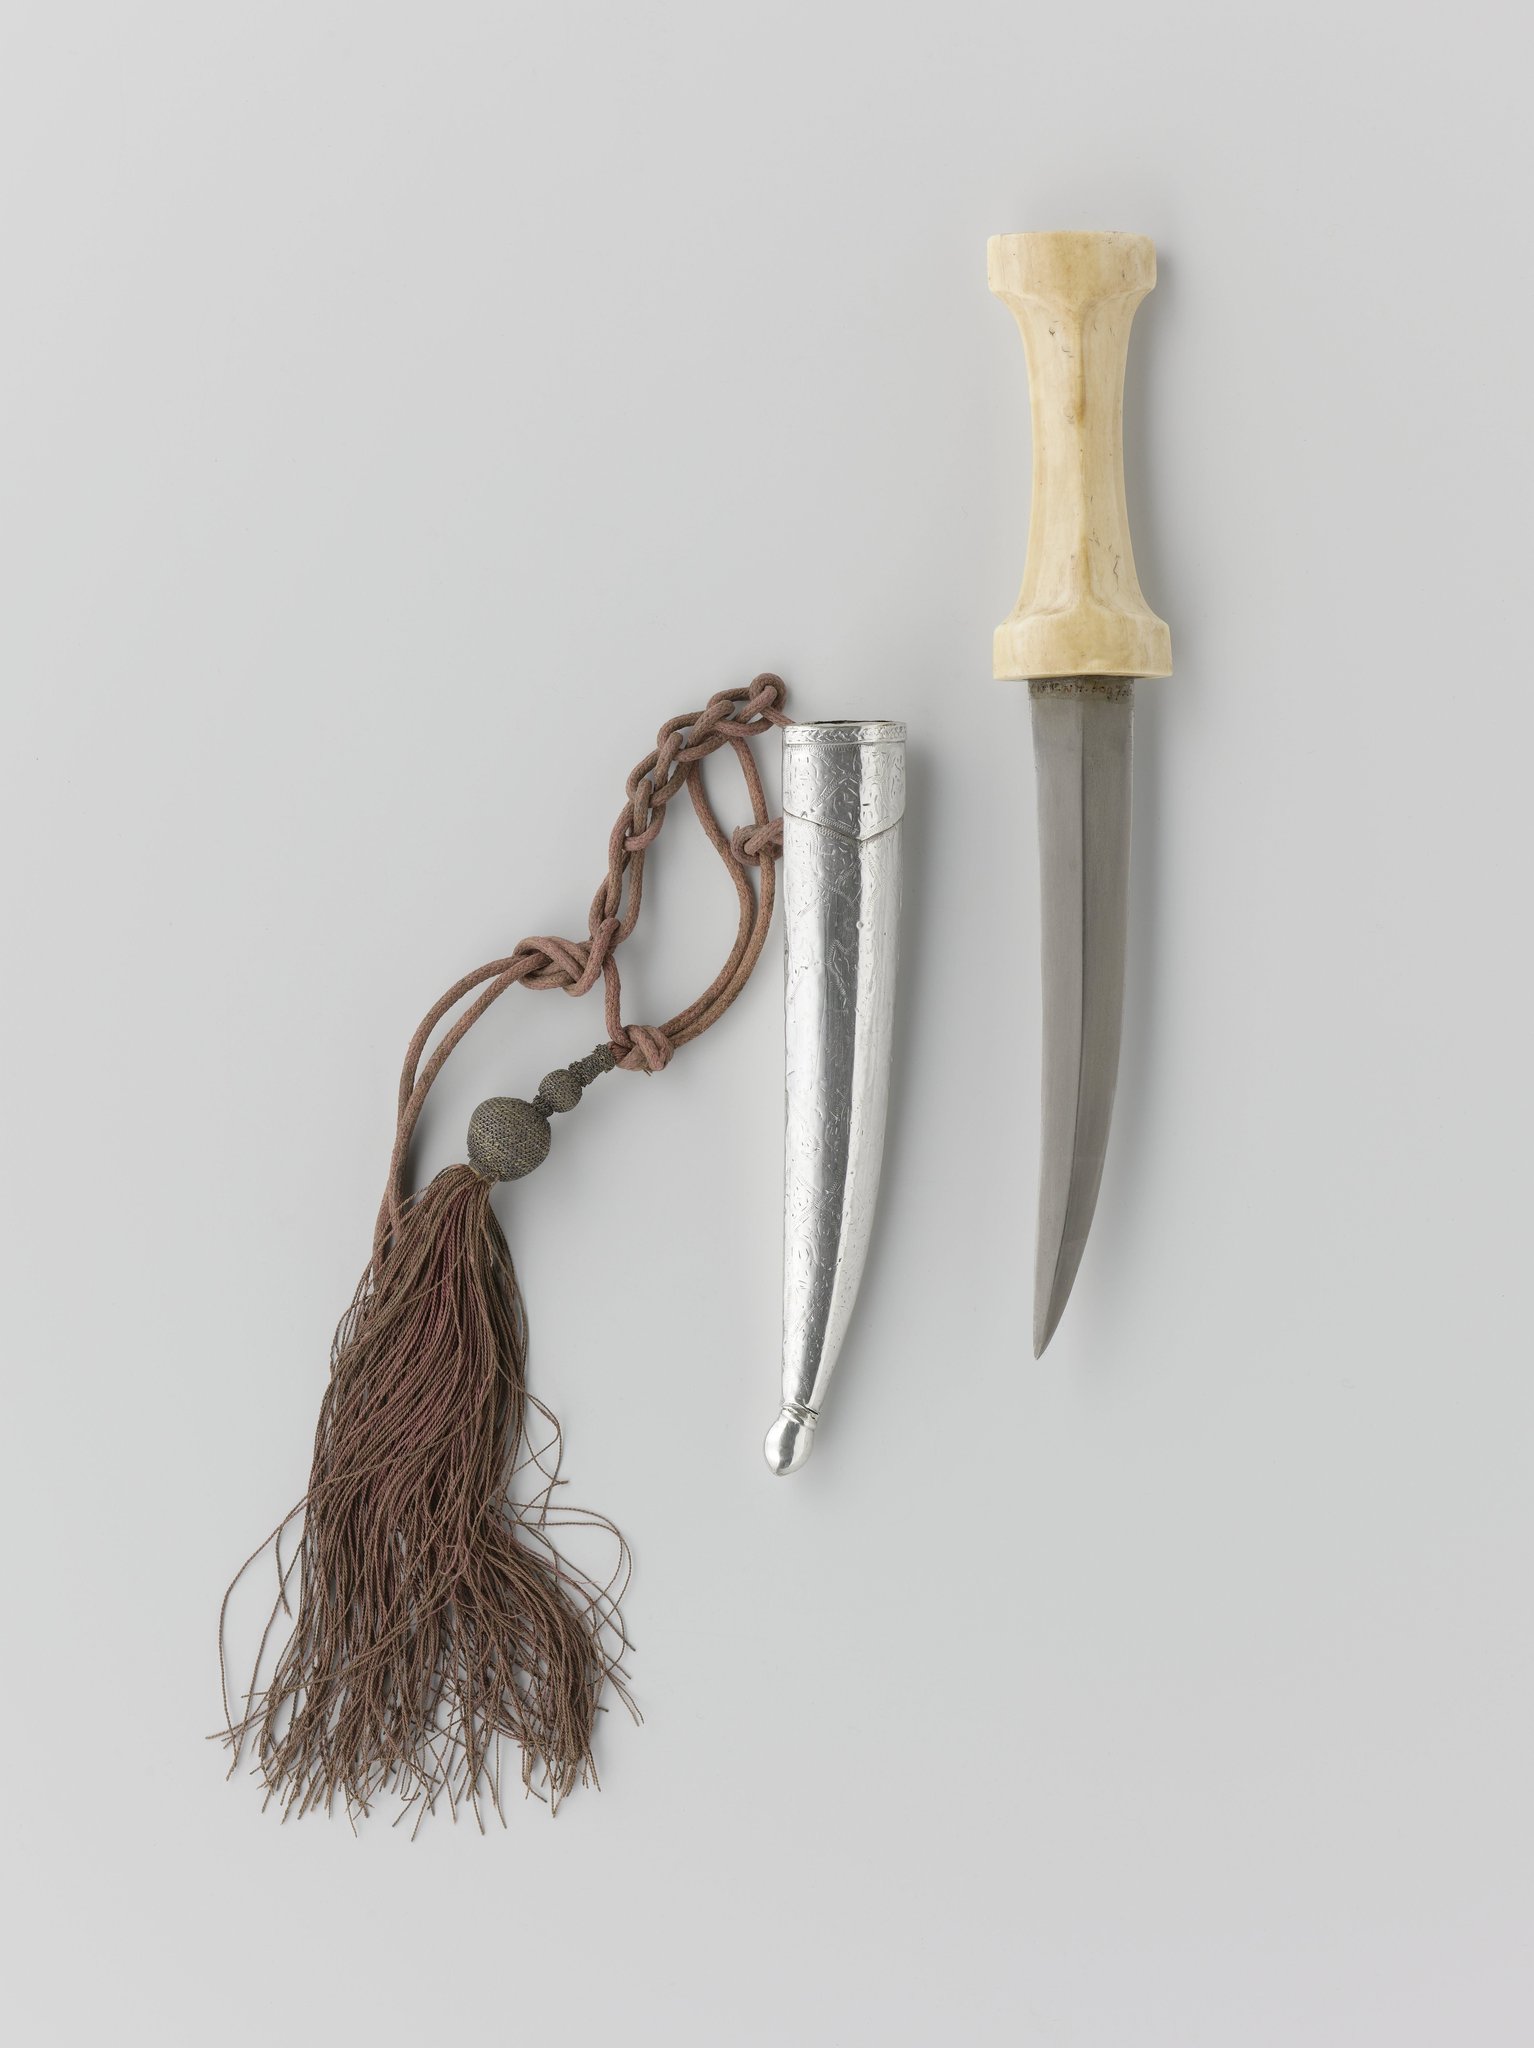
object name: dagger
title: Perzische dolk met schede van Cornelis Tromp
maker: Anonymous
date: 1600-1699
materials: ivory, silver leaf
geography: iran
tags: rotterdam, amsterdam, cornelis tromp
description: Arms collection of Cornelis Tromp. These weapons were kept at the Amsterdam home of Cornelis Tromp. The collection included contemporary weapons of exceptional quality and several exotic weapons acquired for their curiosity value. Tromp probably received many of these weapons as gifts during his patrols of the Mediterranean Sea and in the Baltic.